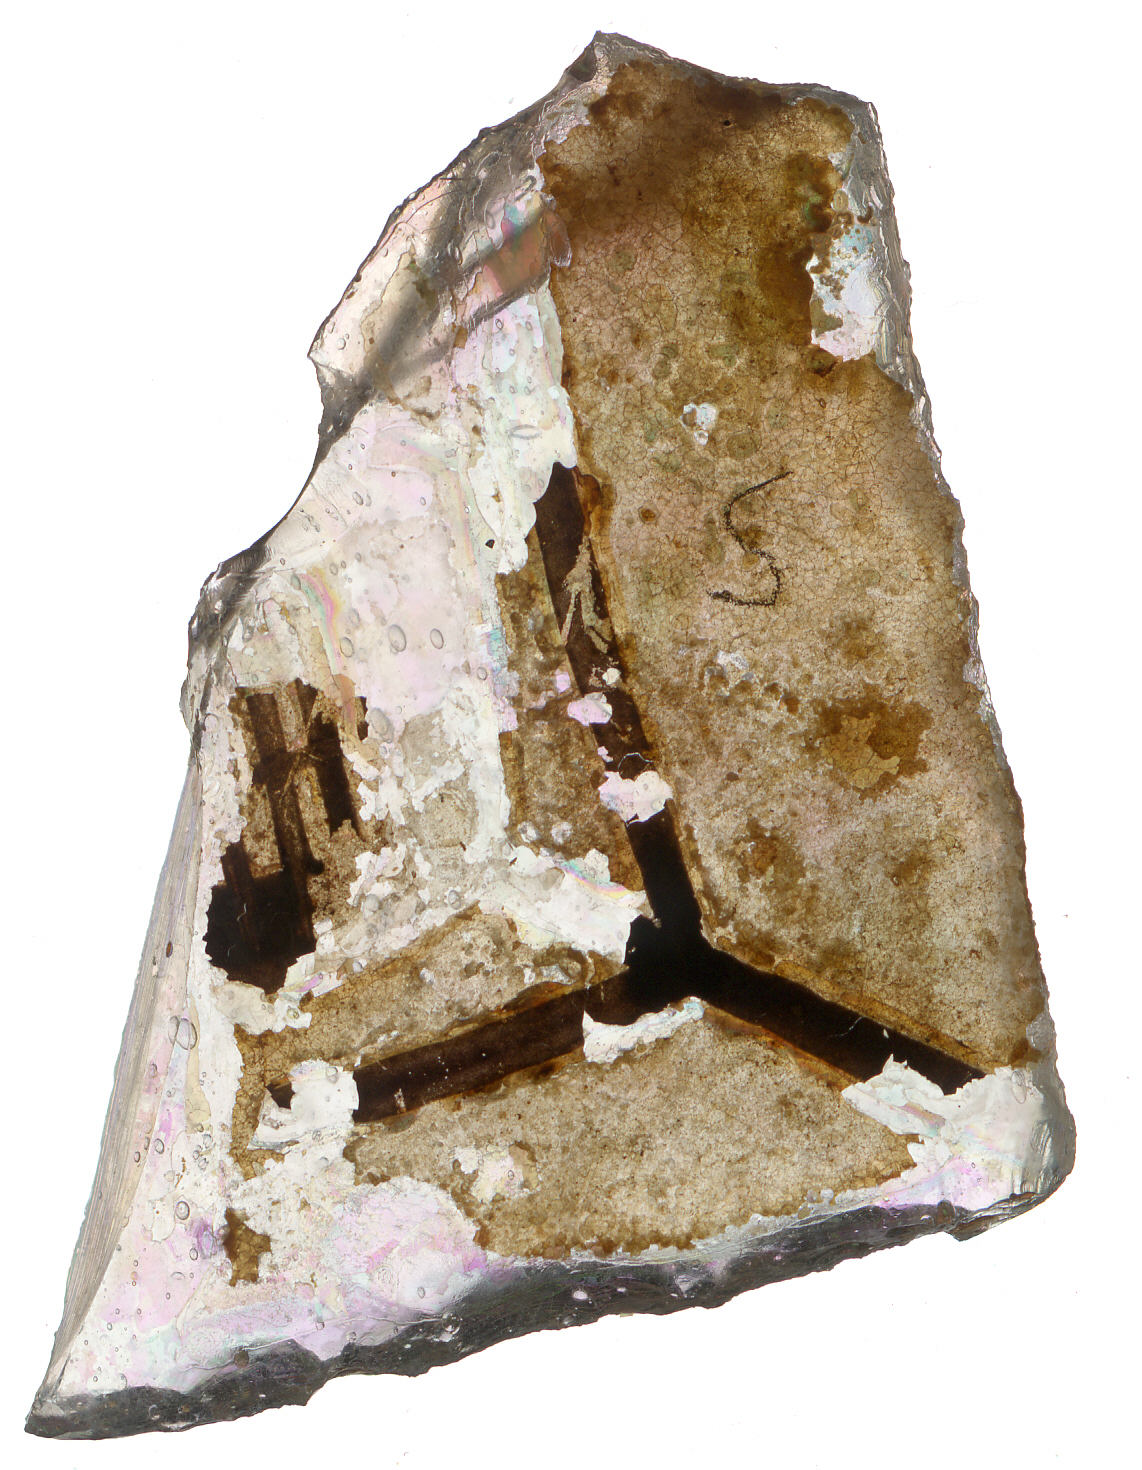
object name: fragment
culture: crusader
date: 1201-1300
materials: glass